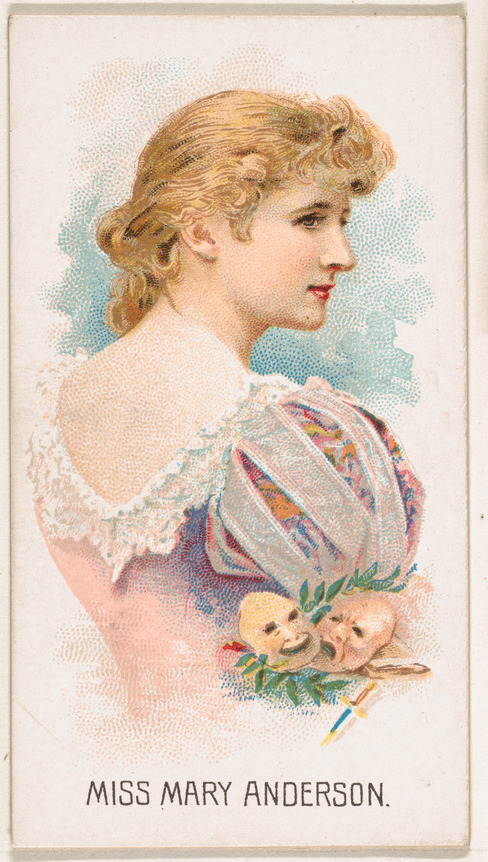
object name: print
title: Miss Mary Anderson, from Leaders series (N222) issued by Kinney Bros.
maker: kinney brothers tobacco company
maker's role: publisher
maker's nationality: american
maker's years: 1869-2011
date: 1888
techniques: color lithograph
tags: profiles,women